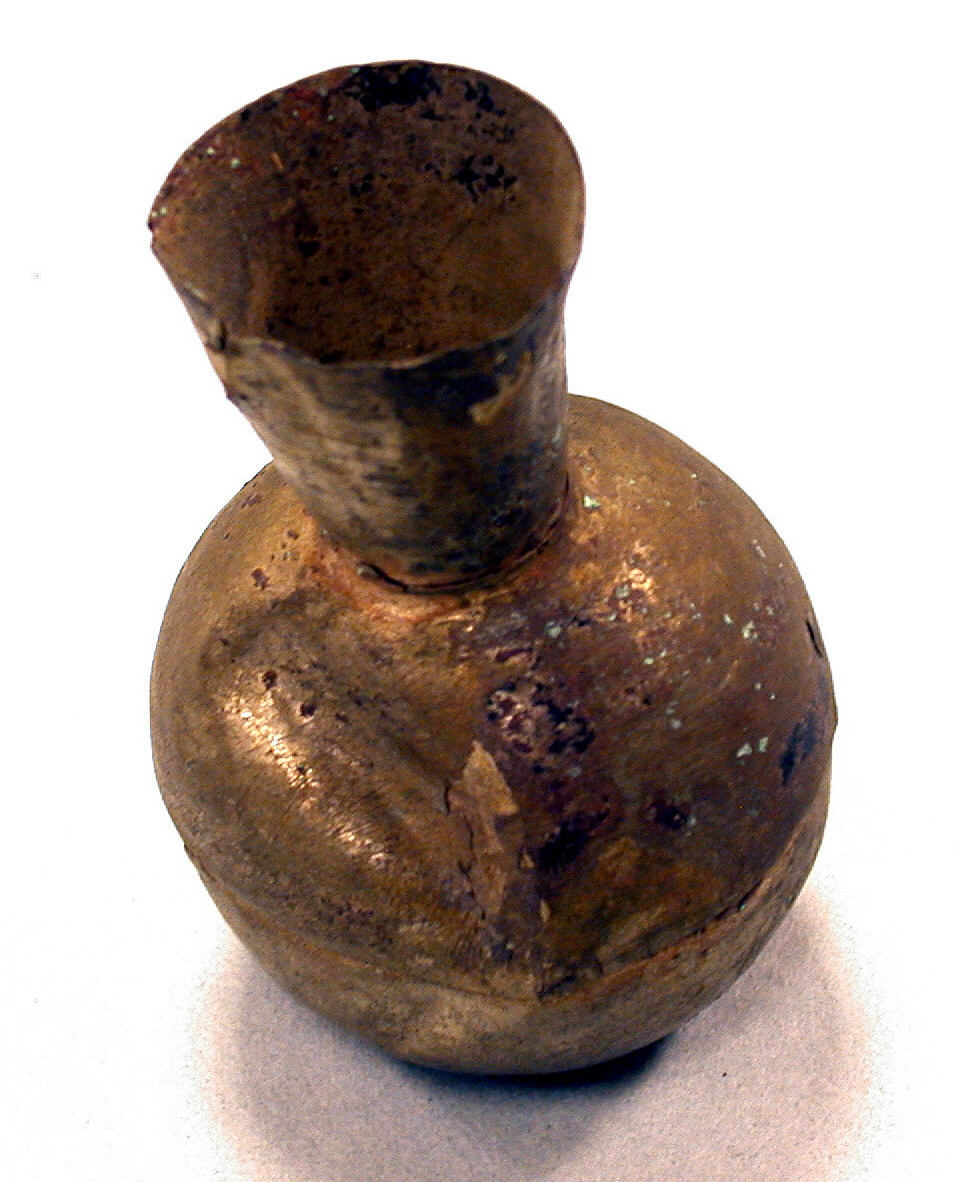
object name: bottle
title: Miniature Bottle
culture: chancay or chimú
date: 1001-1500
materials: gilt, silver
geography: peru